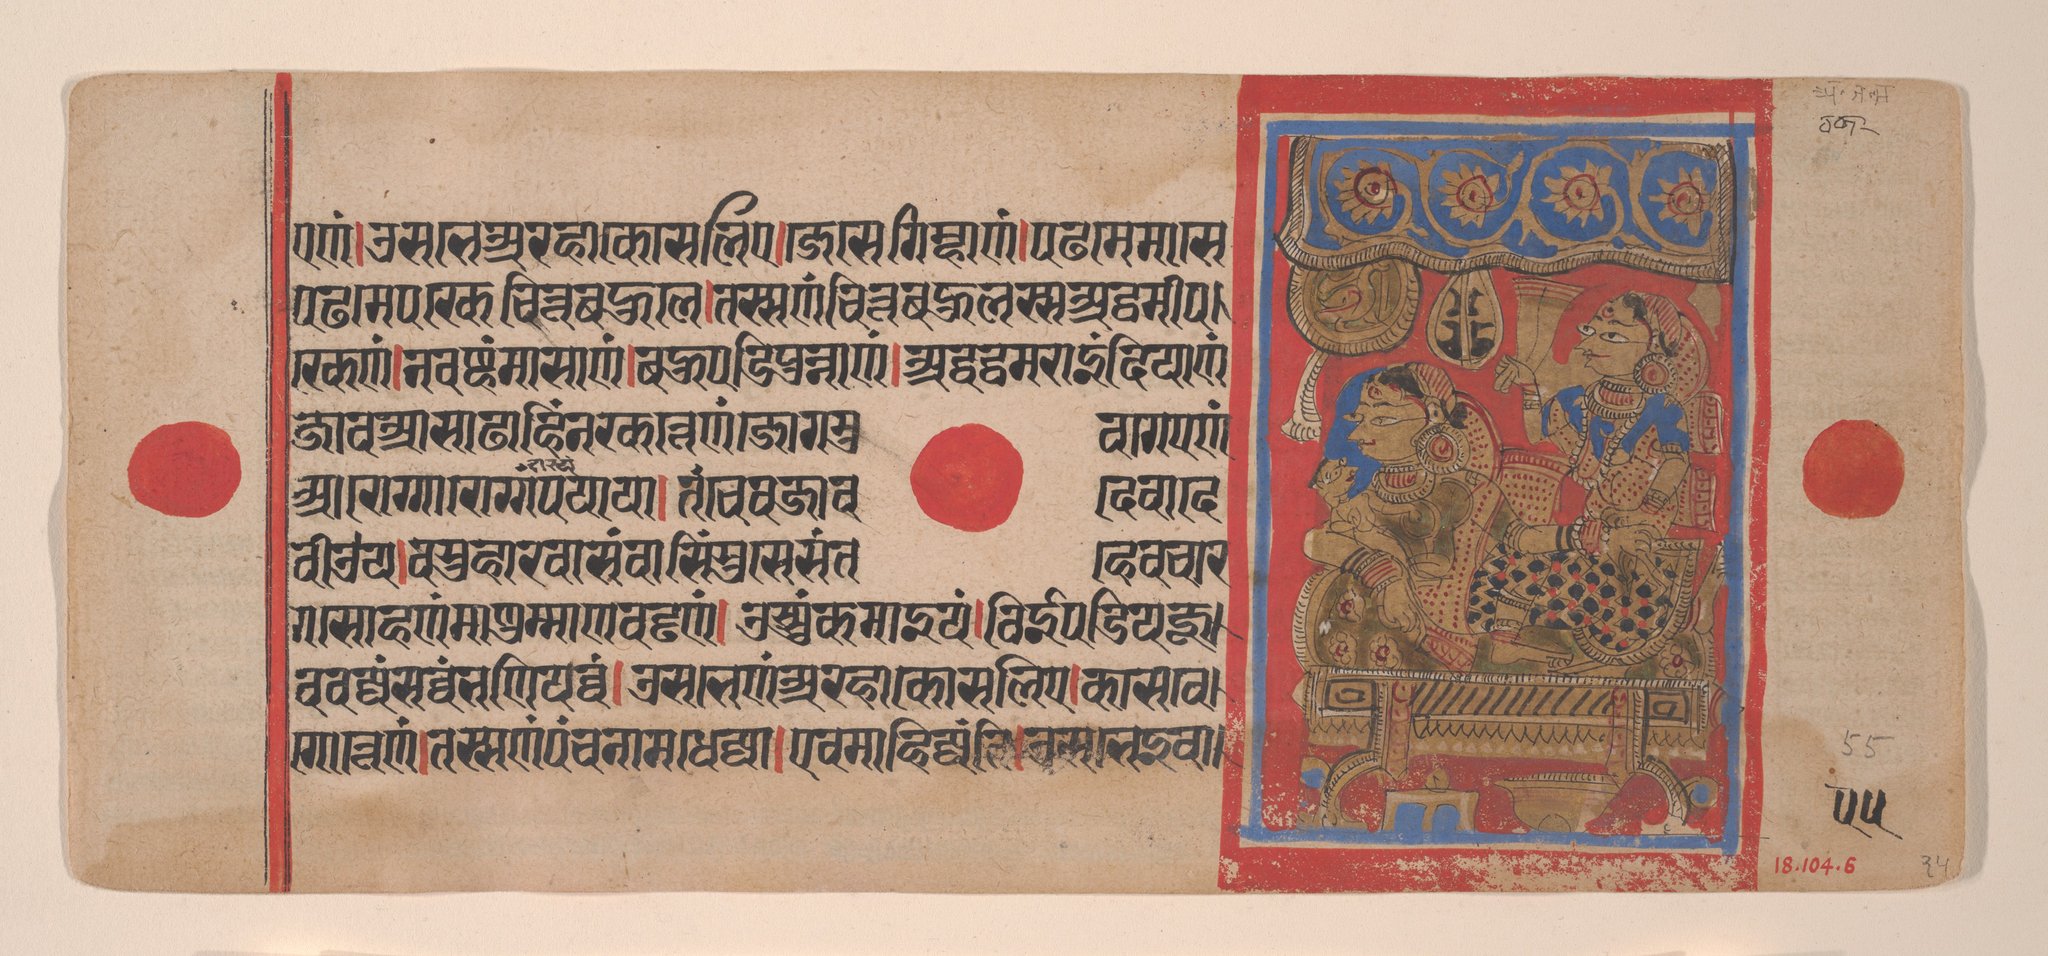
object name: manuscript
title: Queen Trisala and the Newborn Mahavira: Folio from a Kalpasutra Manuscript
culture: indian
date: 1461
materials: gold, ink, paper, watercolor